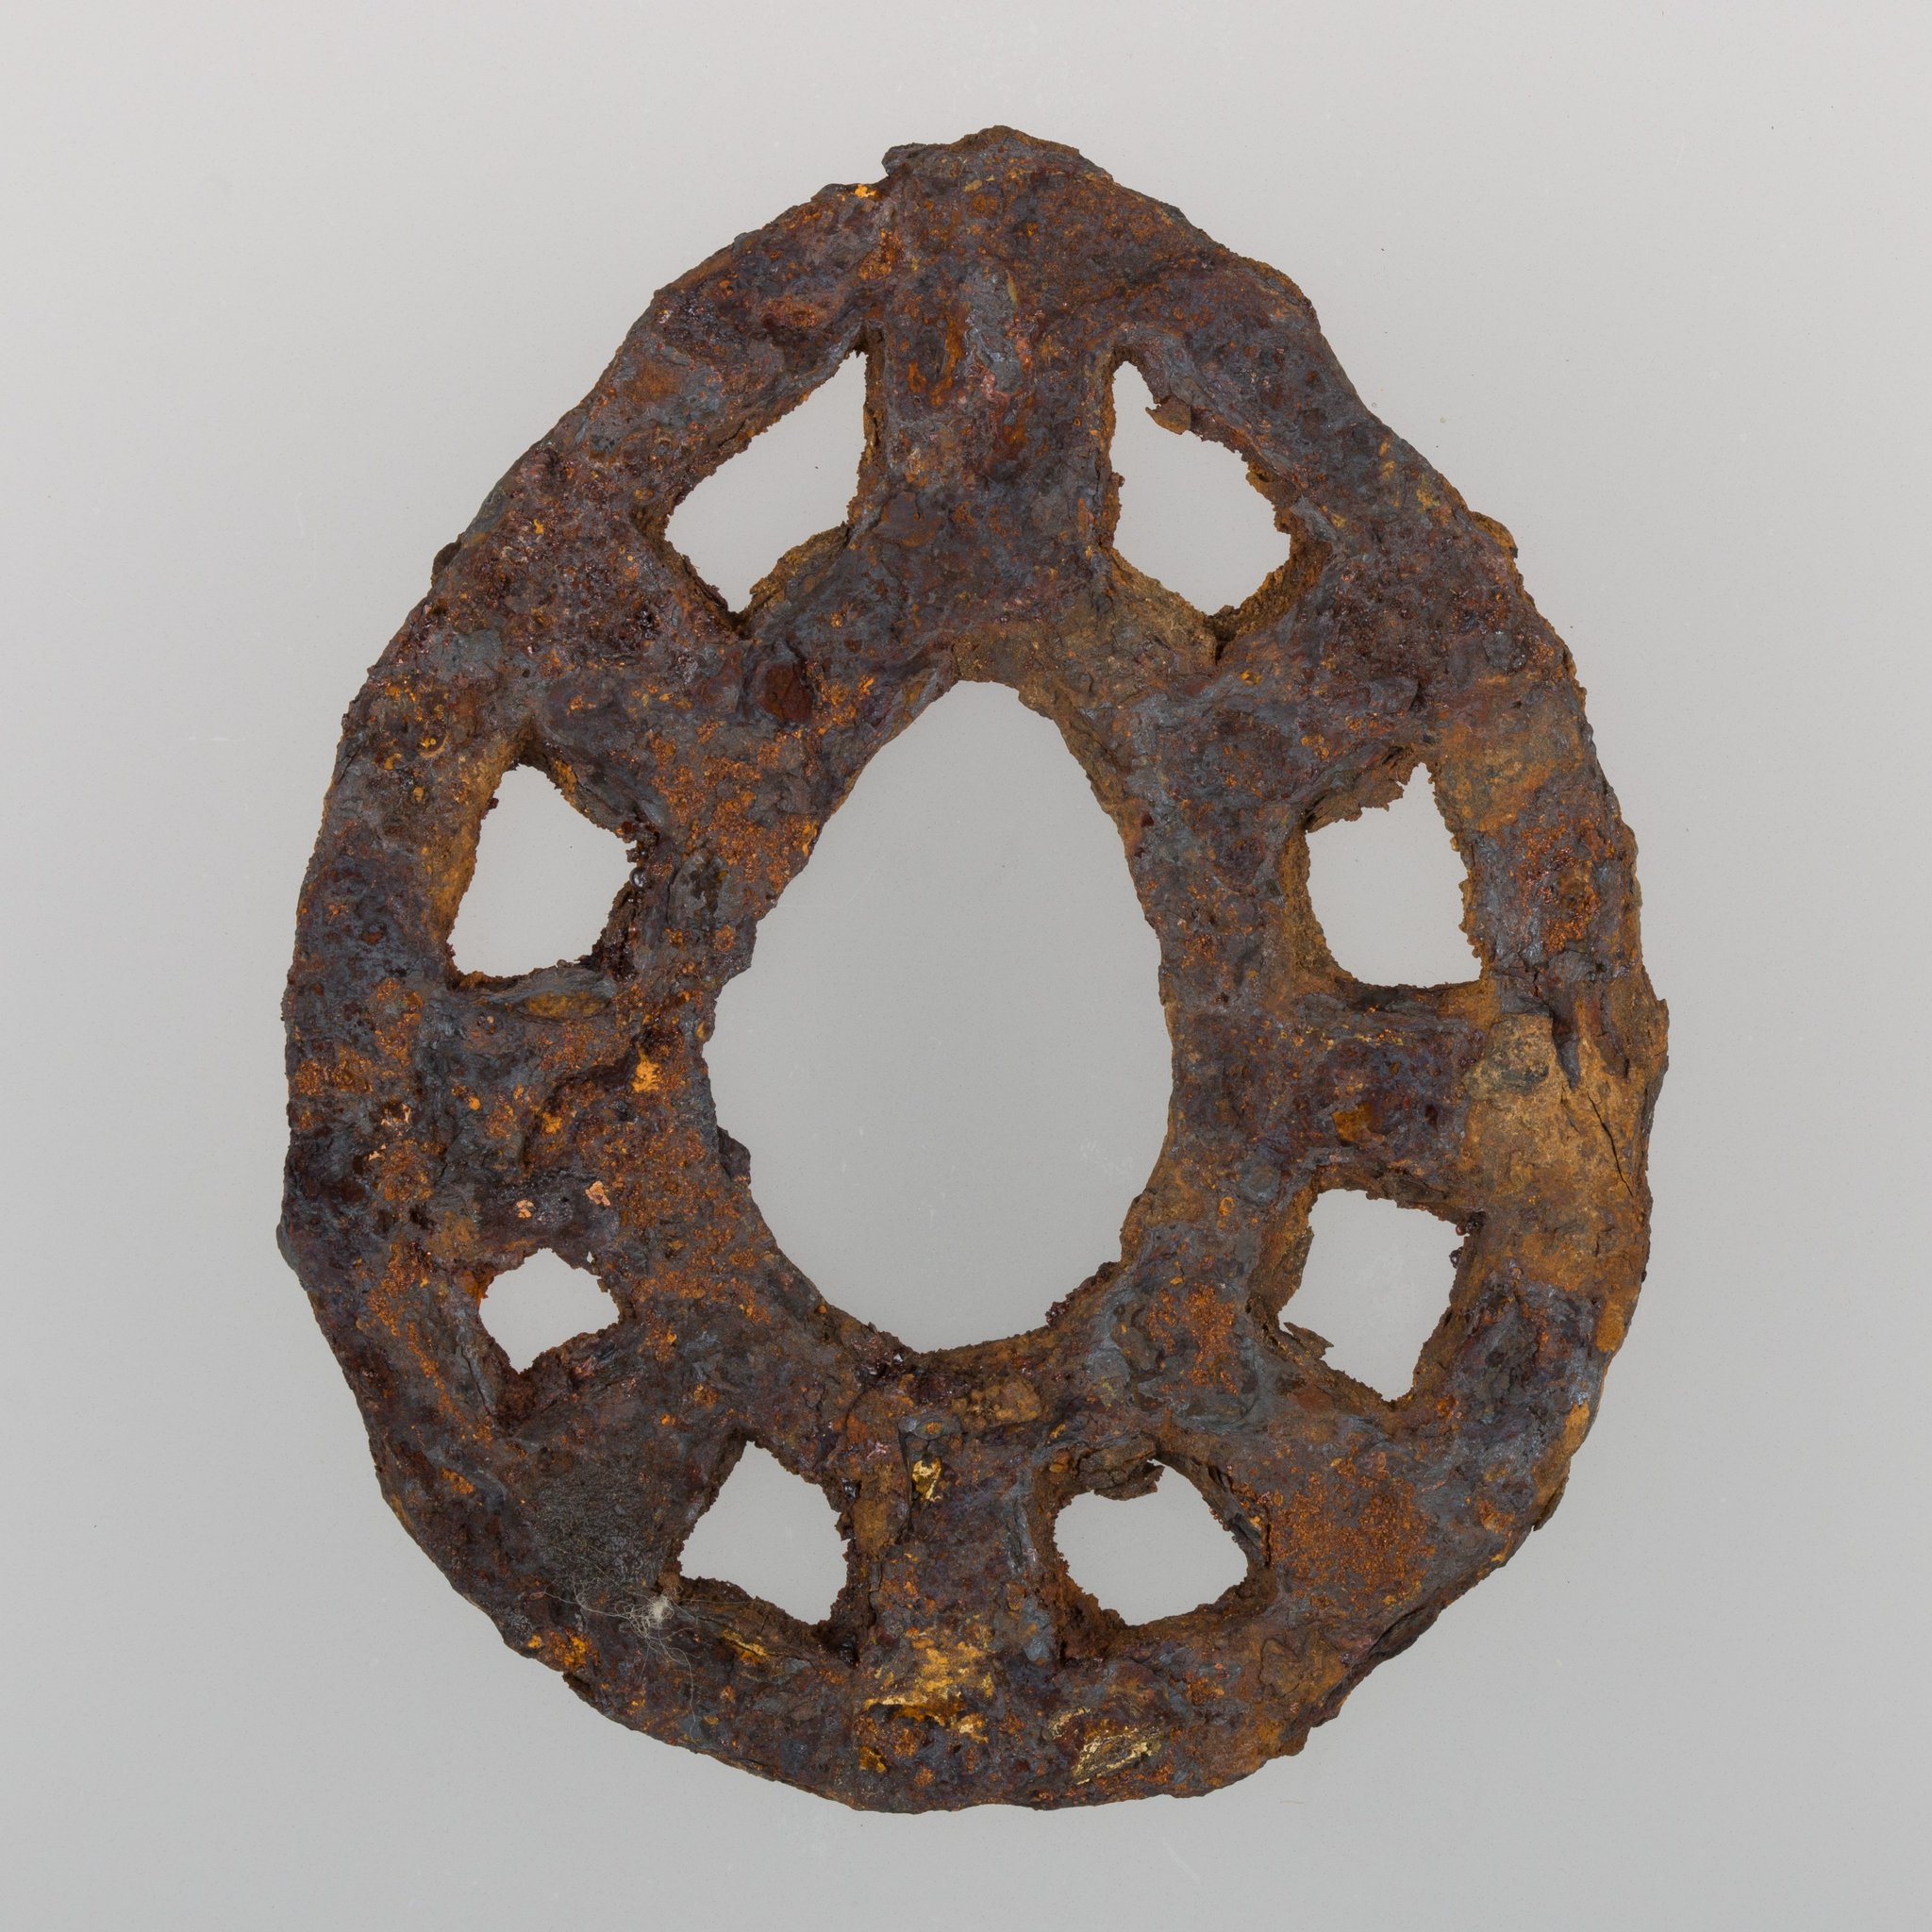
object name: sword guard tsuba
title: Sword Guard (Tsuba)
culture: japanese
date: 201-300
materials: iron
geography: japan